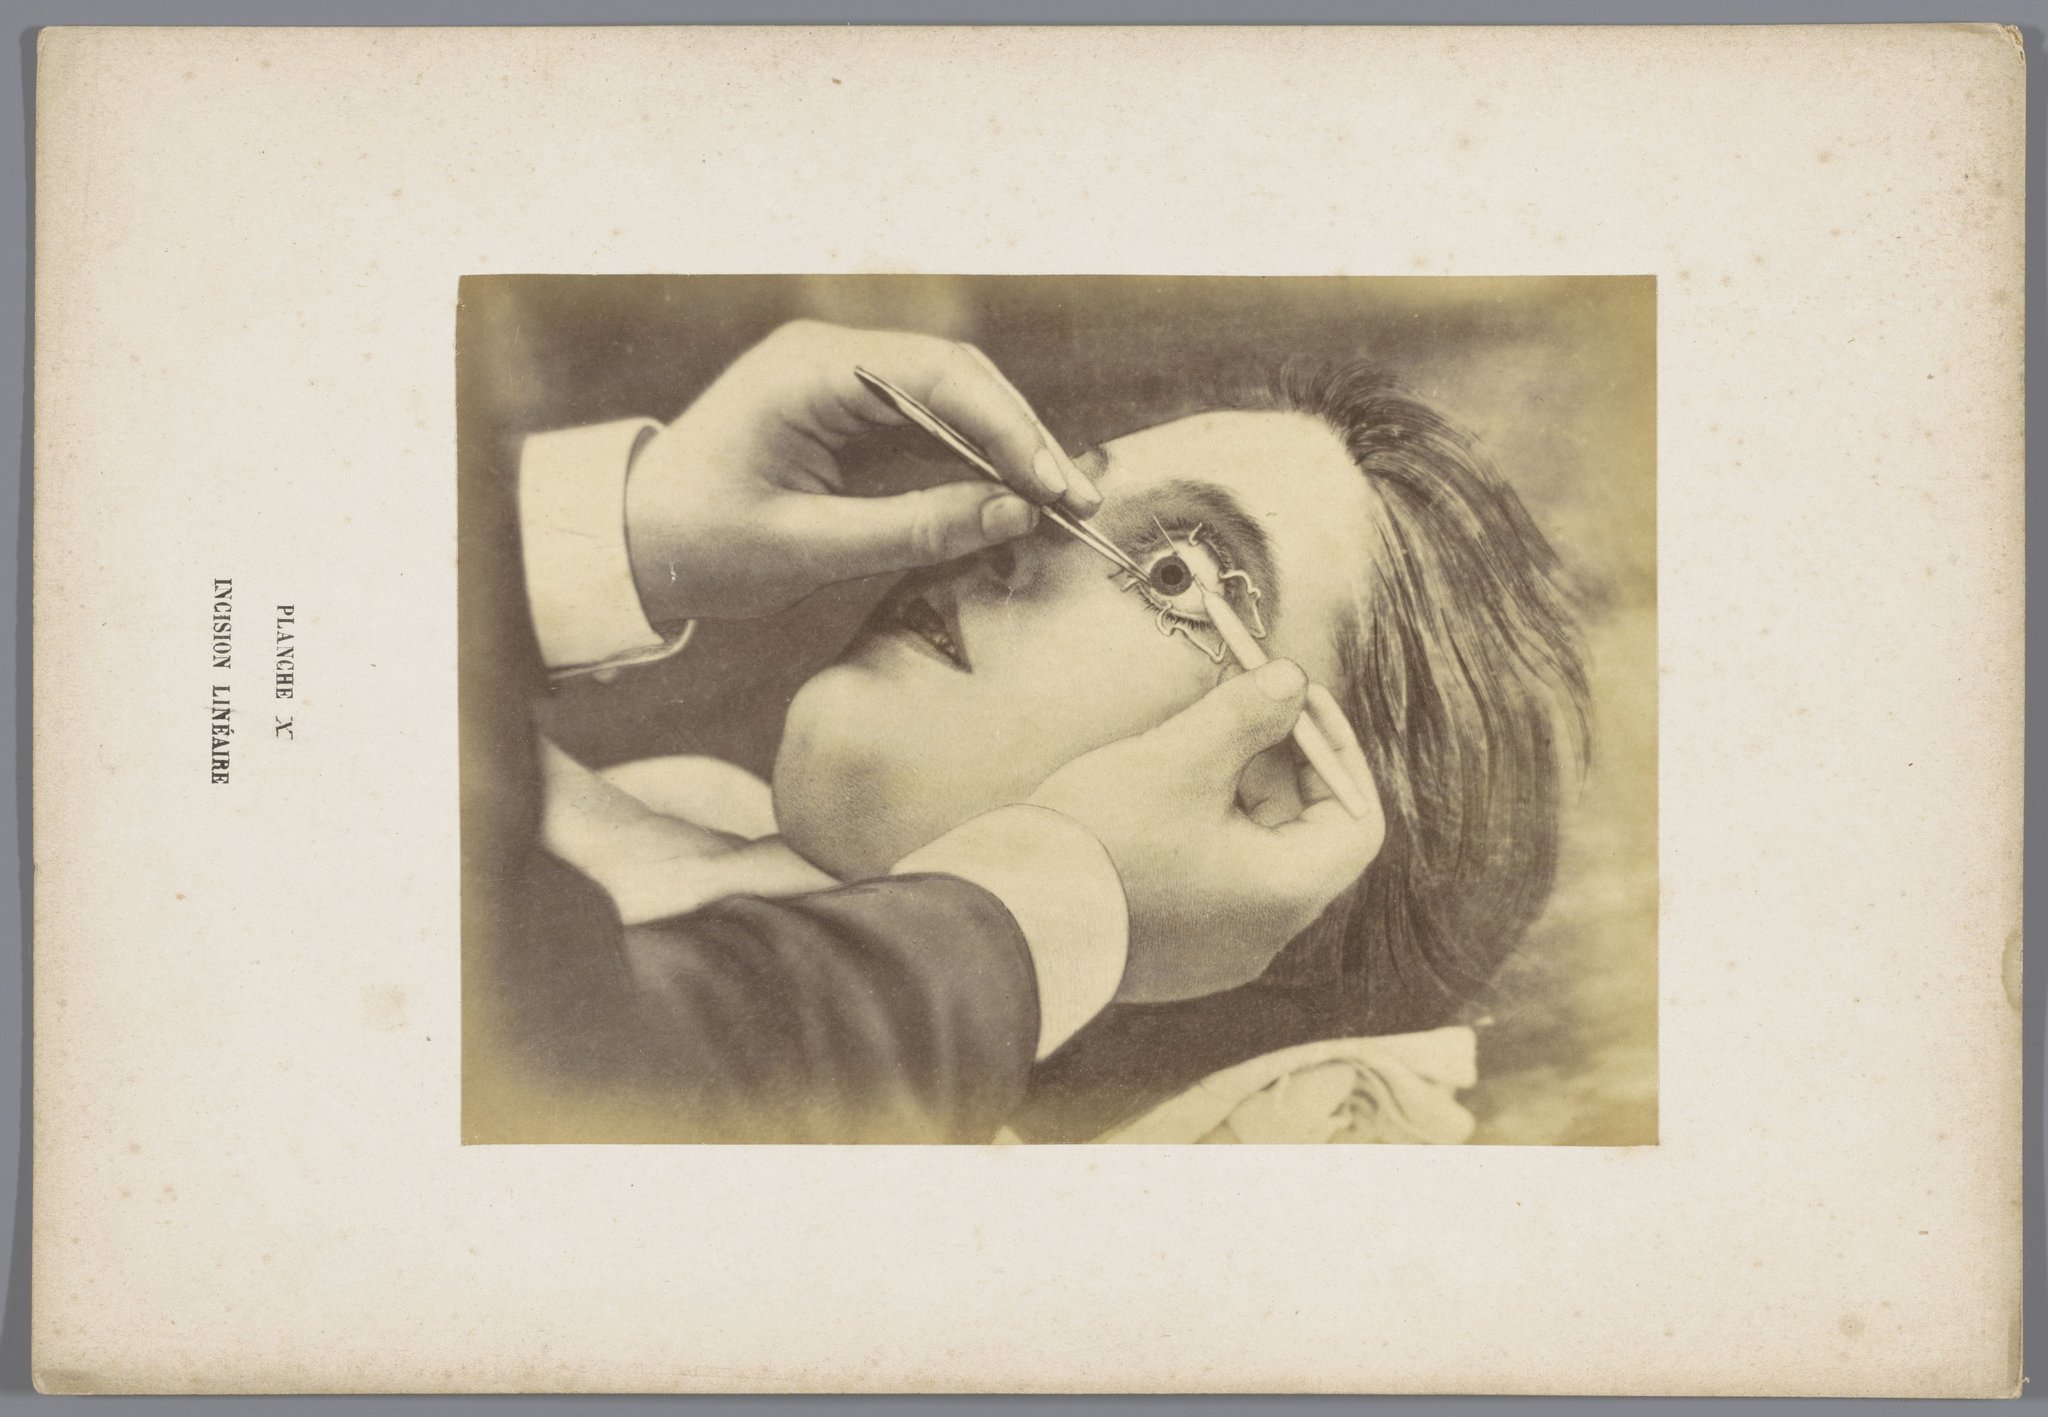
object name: page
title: Incision linéaire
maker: a. de montméja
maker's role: arts, fotograaf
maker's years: 1841-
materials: photographic support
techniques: albumen print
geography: france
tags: eyes, operation, surgery, disabilities affecting the eyes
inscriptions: number: ‘Planche X’